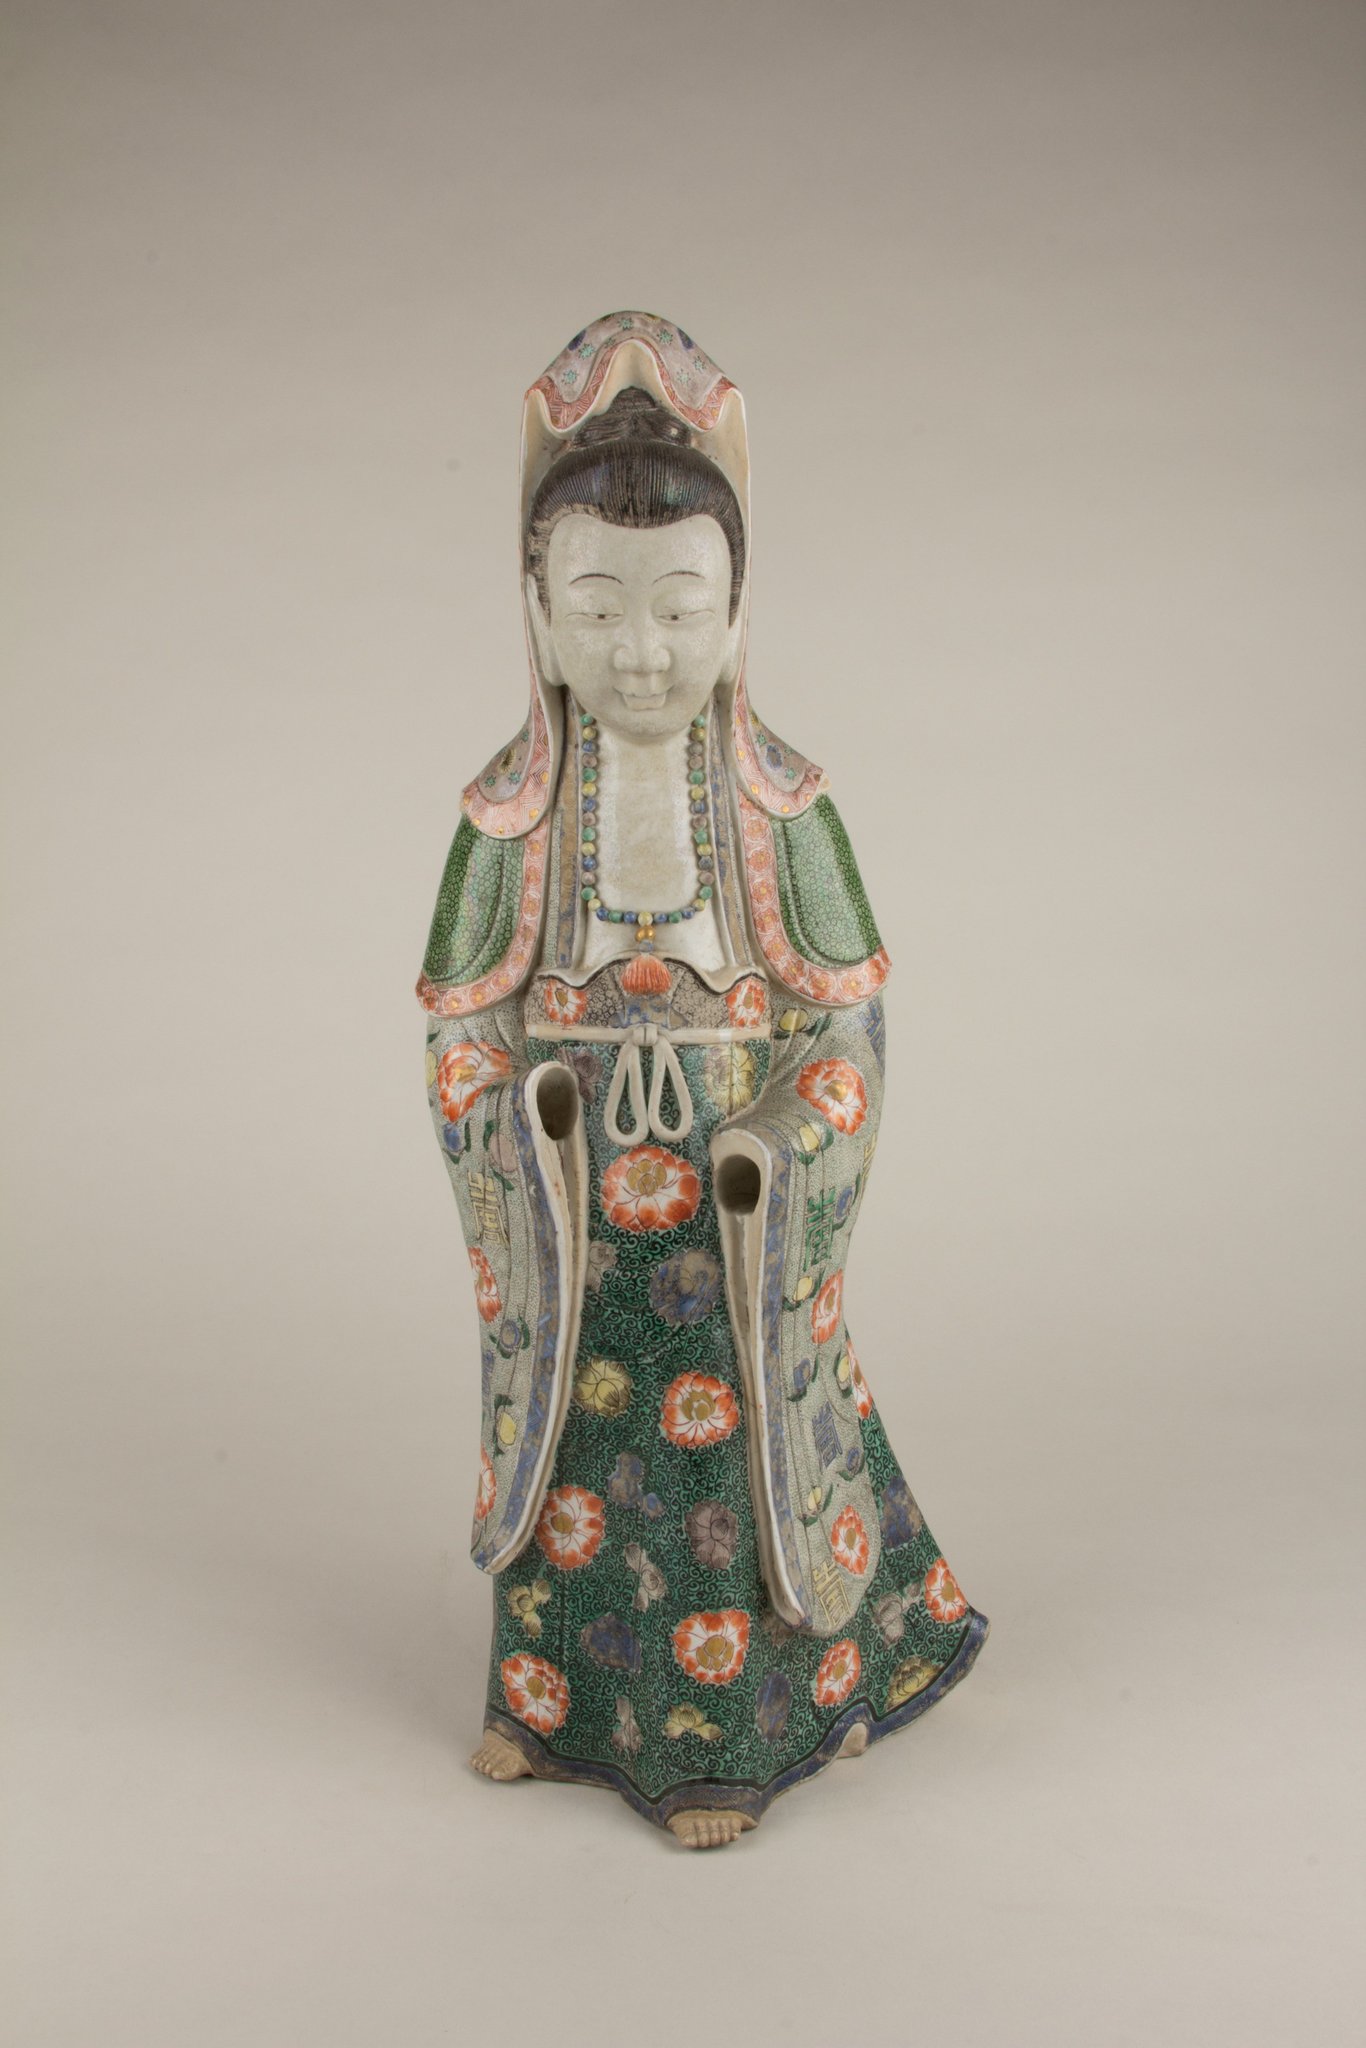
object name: figure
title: Figure of Guanyin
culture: chinese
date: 1662-1722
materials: porcelain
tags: goddess